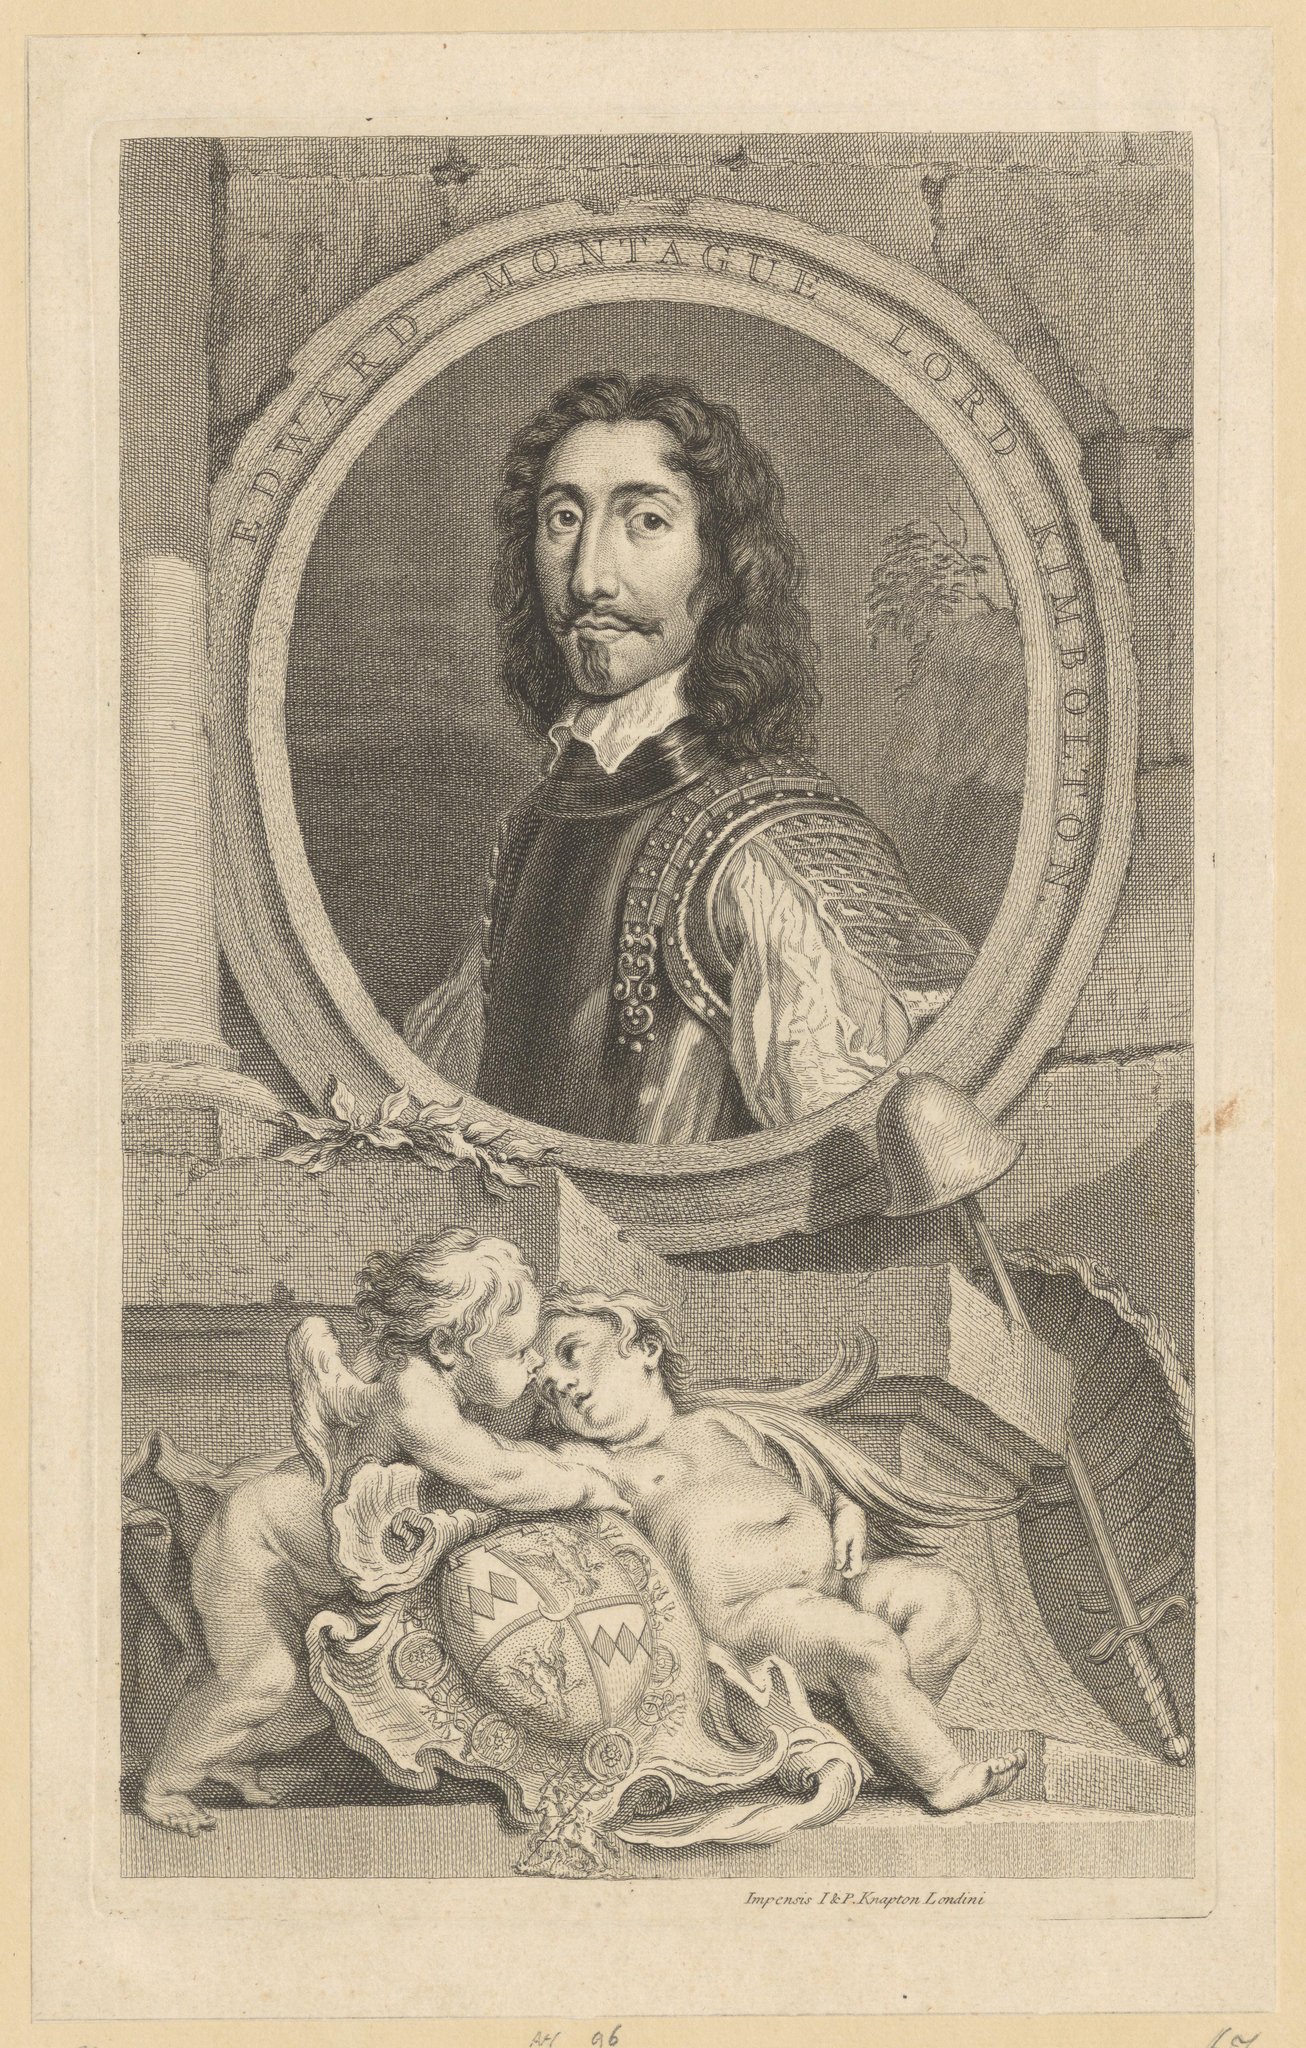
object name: print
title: Portret van Edward Montagu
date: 1694-1747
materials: paper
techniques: engraving, etching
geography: london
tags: politician, historical persons, politician, e.g. party leader, cupids: 'amores', 'amoretti', 'putti', armorial bearing, heraldry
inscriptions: collector's mark: Lugt 240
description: Prent gebruikt in: Birch, Thomas. The heads of illustrious persons of Great Britain (...). Londen: John & Paul Knapton, 1747, p. 30.